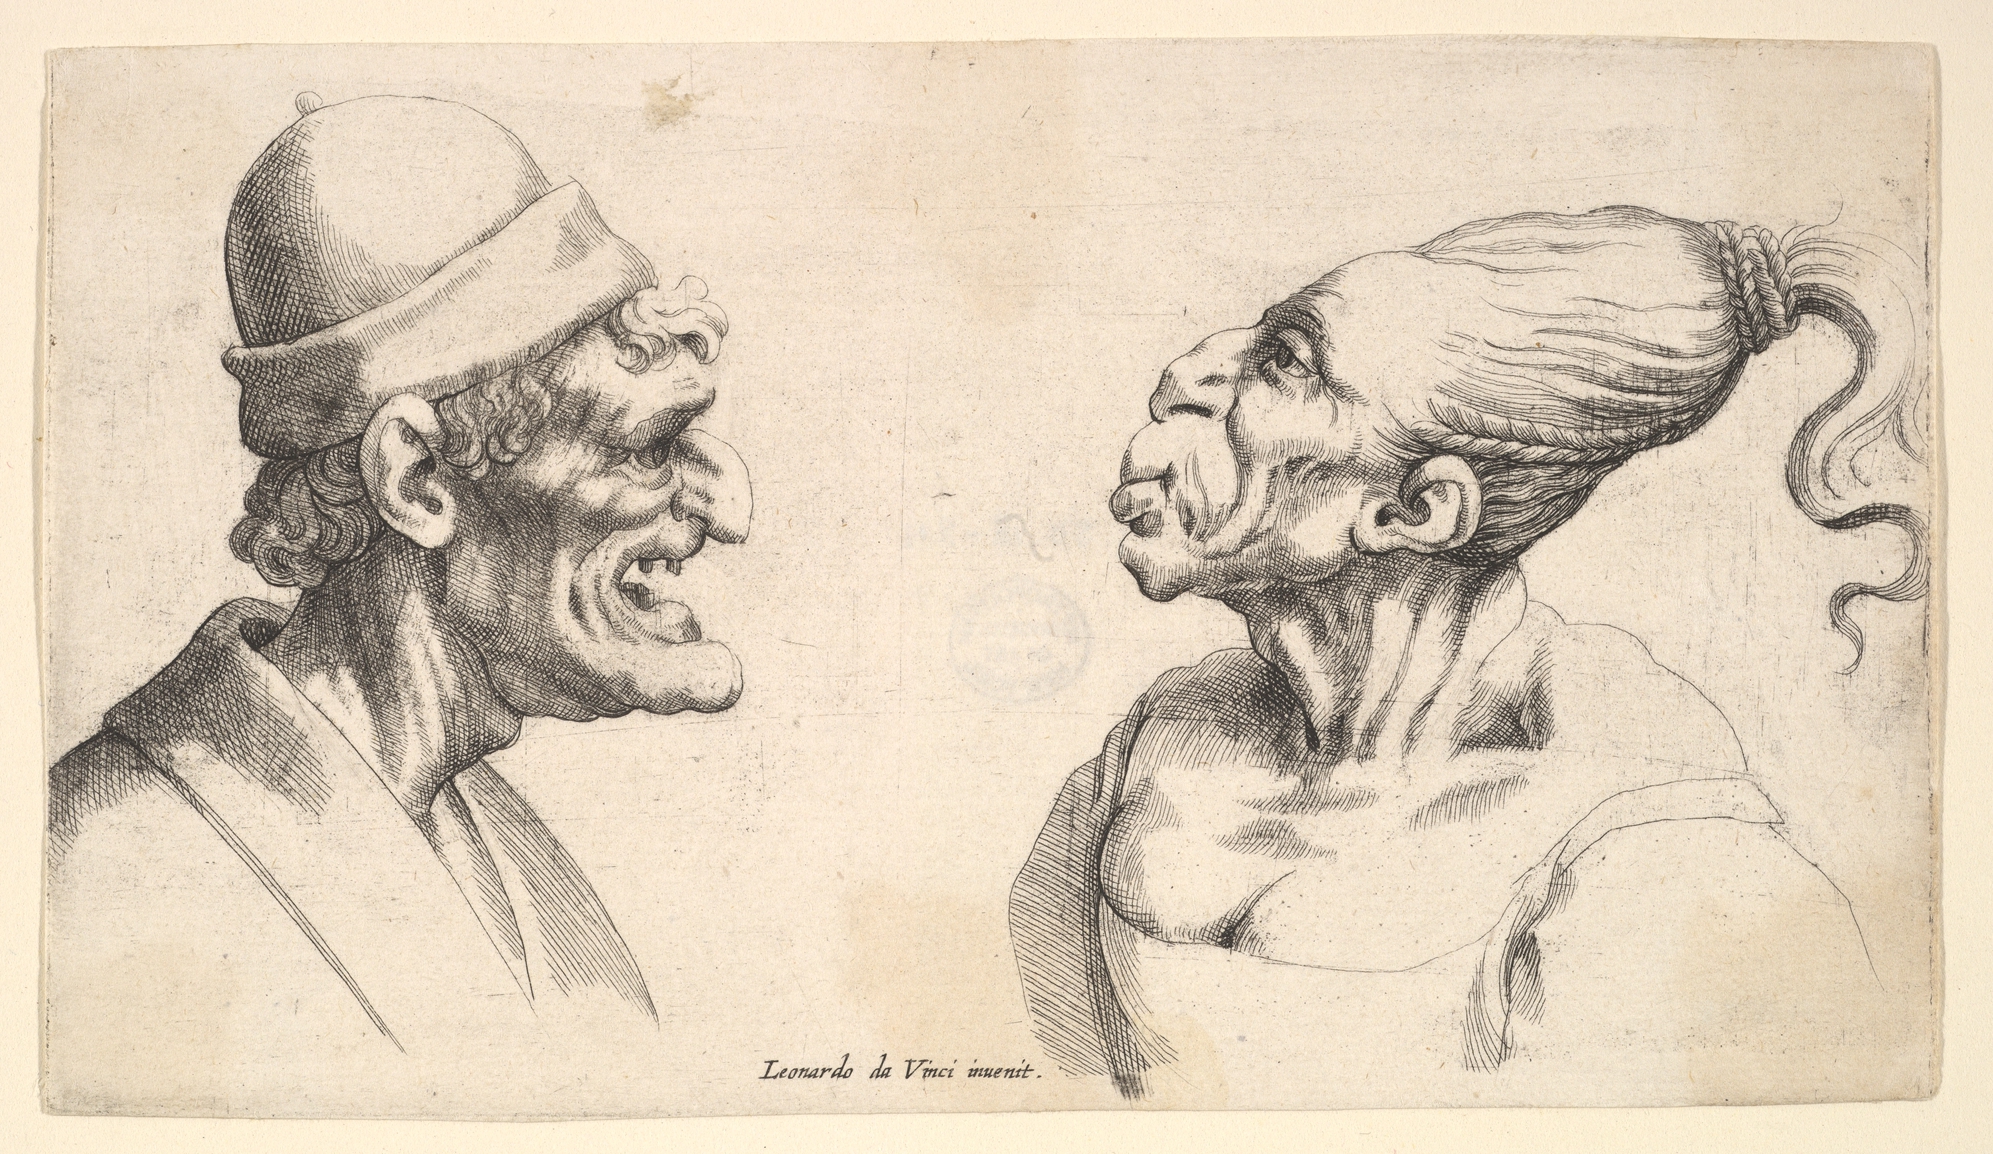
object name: print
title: Two deformed heads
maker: wenceslaus hollar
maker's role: artist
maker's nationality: bohemian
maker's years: 1607-1677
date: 1645-1650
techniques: engraving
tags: heads